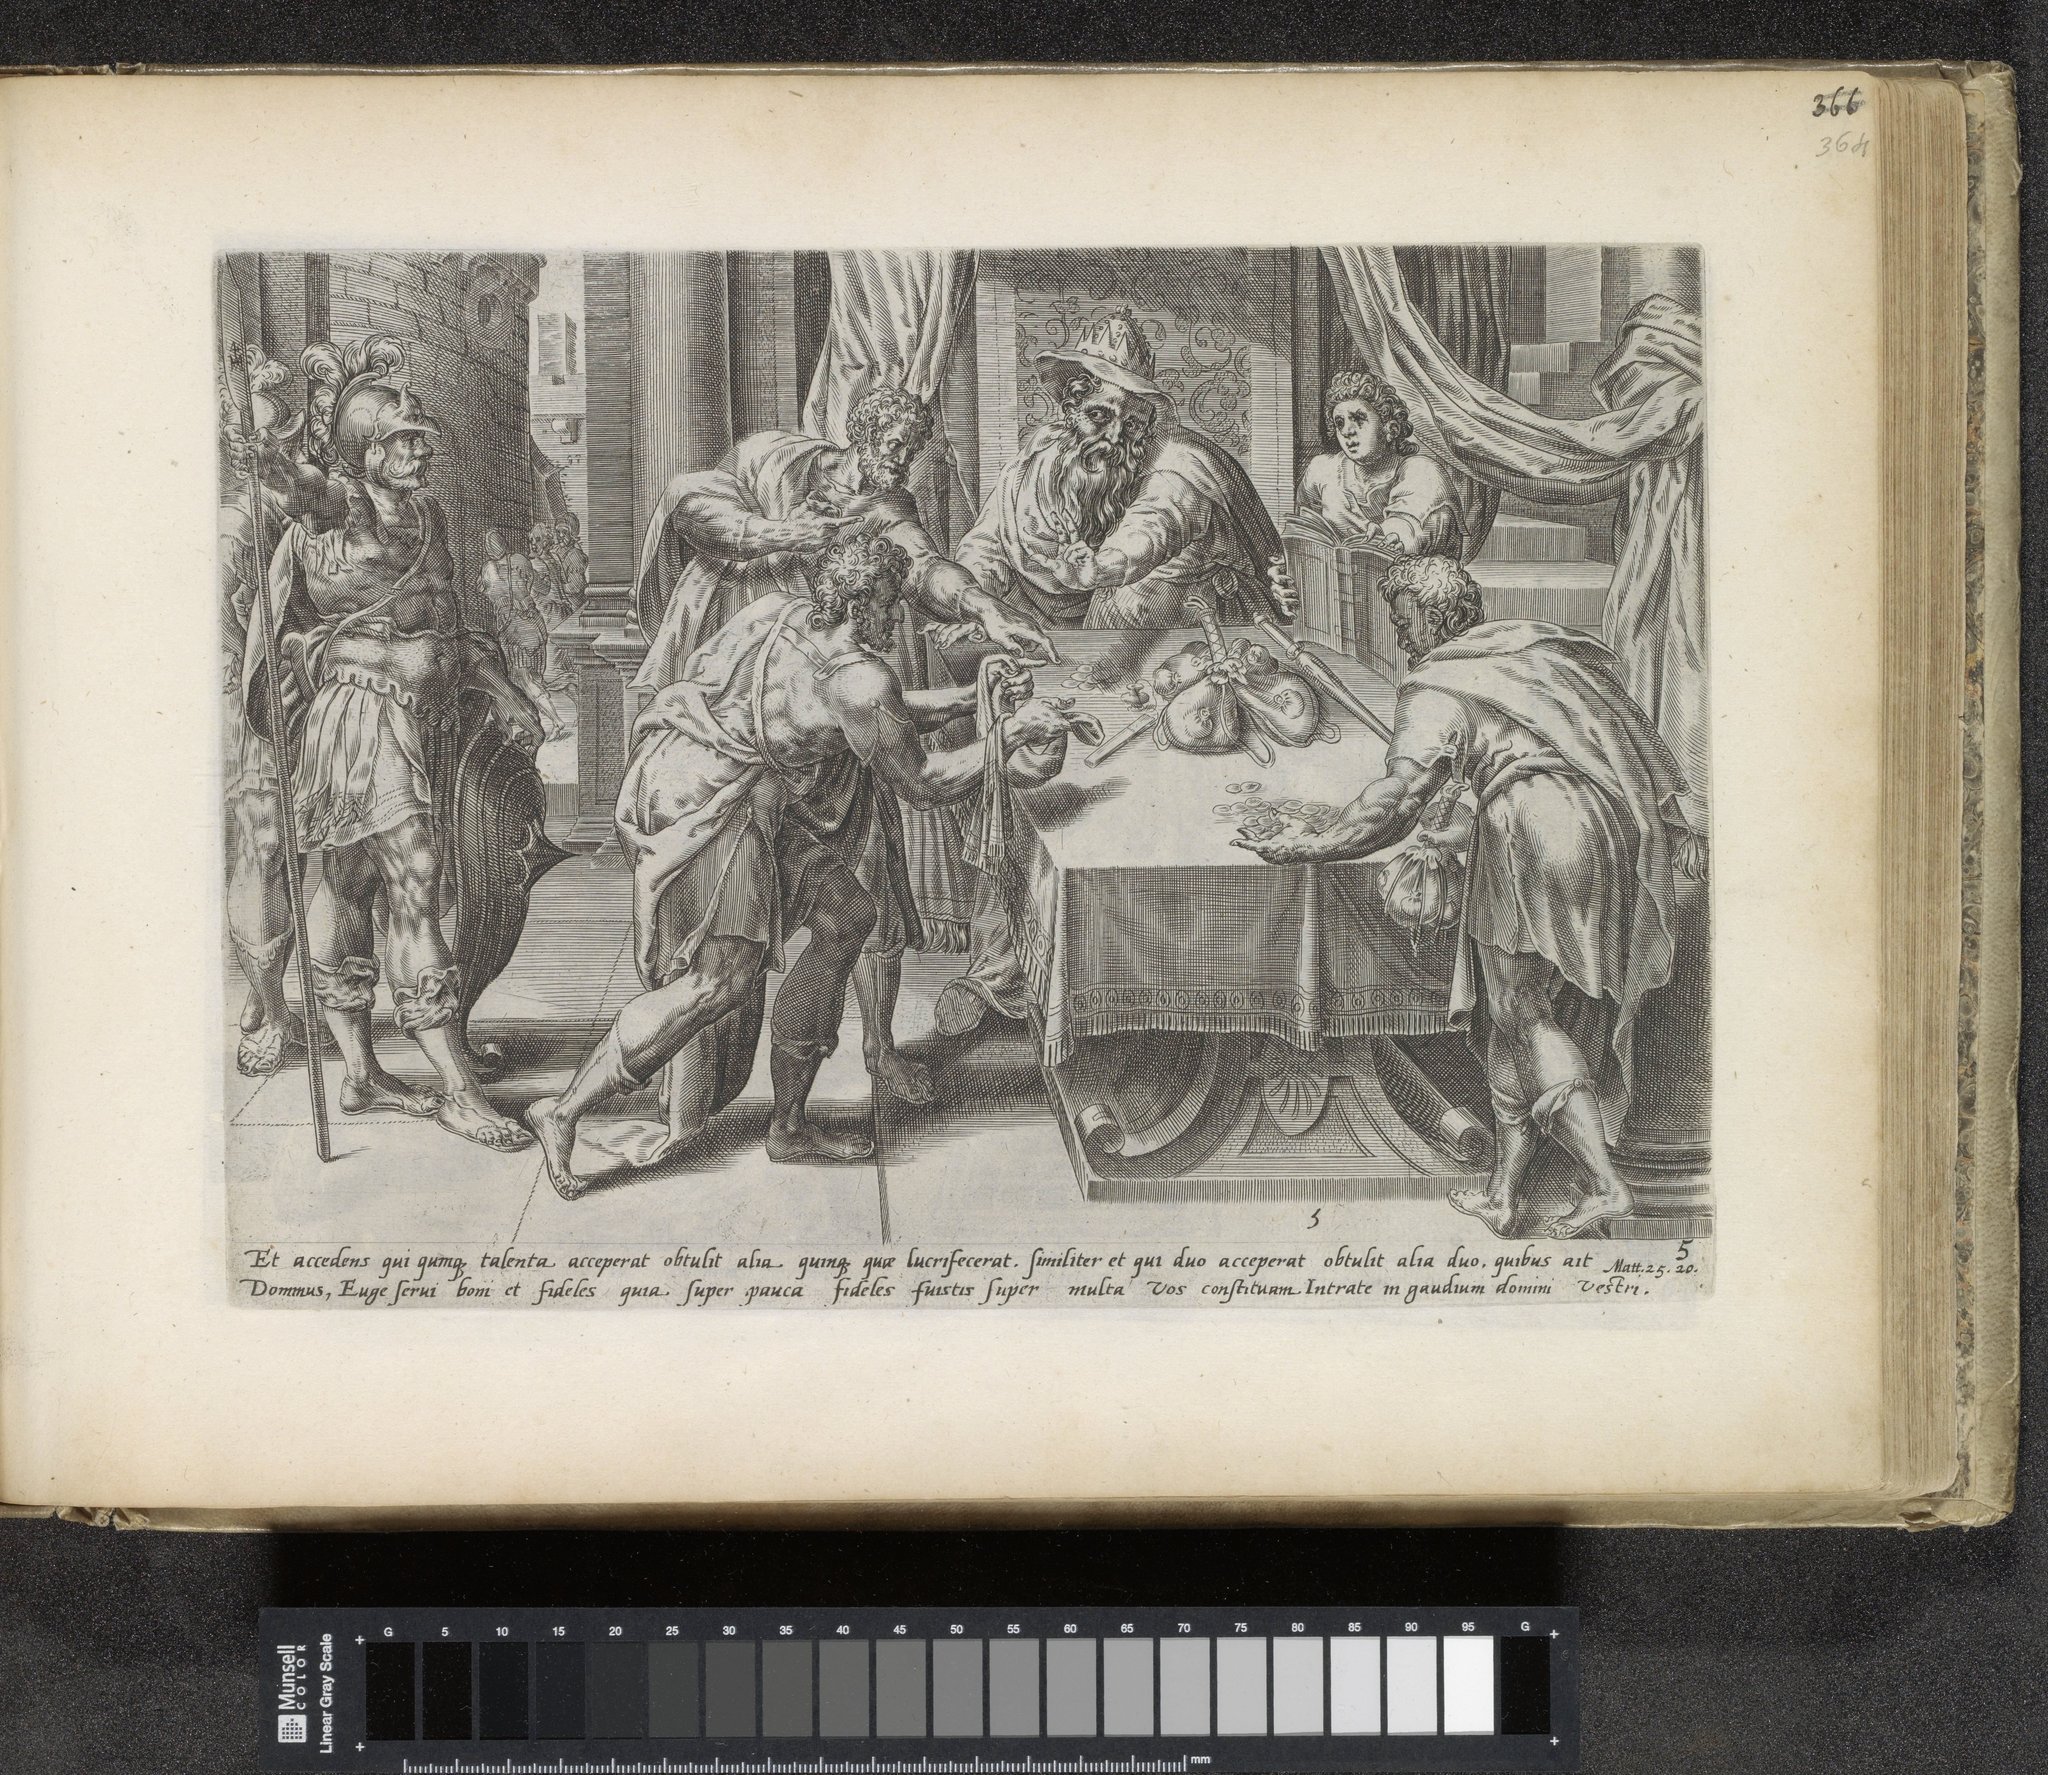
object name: album leaf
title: Theatrum Biblicum Hoc Est Historiae Sacrae Veteris et Novi Testamenti Tabulis Aeneis Expressae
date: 1565-1572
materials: paper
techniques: engraving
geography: amsterdam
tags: after the return of the lord the servants account for their debts and are rewarded accordingly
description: De heer vraagt zijn drie dienaren om rekenschap. Degenen met vijf talenten en twee talenten hebben allebei hetzelfde bedrag erbij verdiend. De laatste dienaar legt zijn bundel met een talent op tafel en geeft de heer precies hetzelfde terug als wat hij gekregen had. Onder de voorstelling een verwijzing in het Latijn naar de Bijbeltekst in Mat. 25:20. Deze prent maakt deel uit van een album.